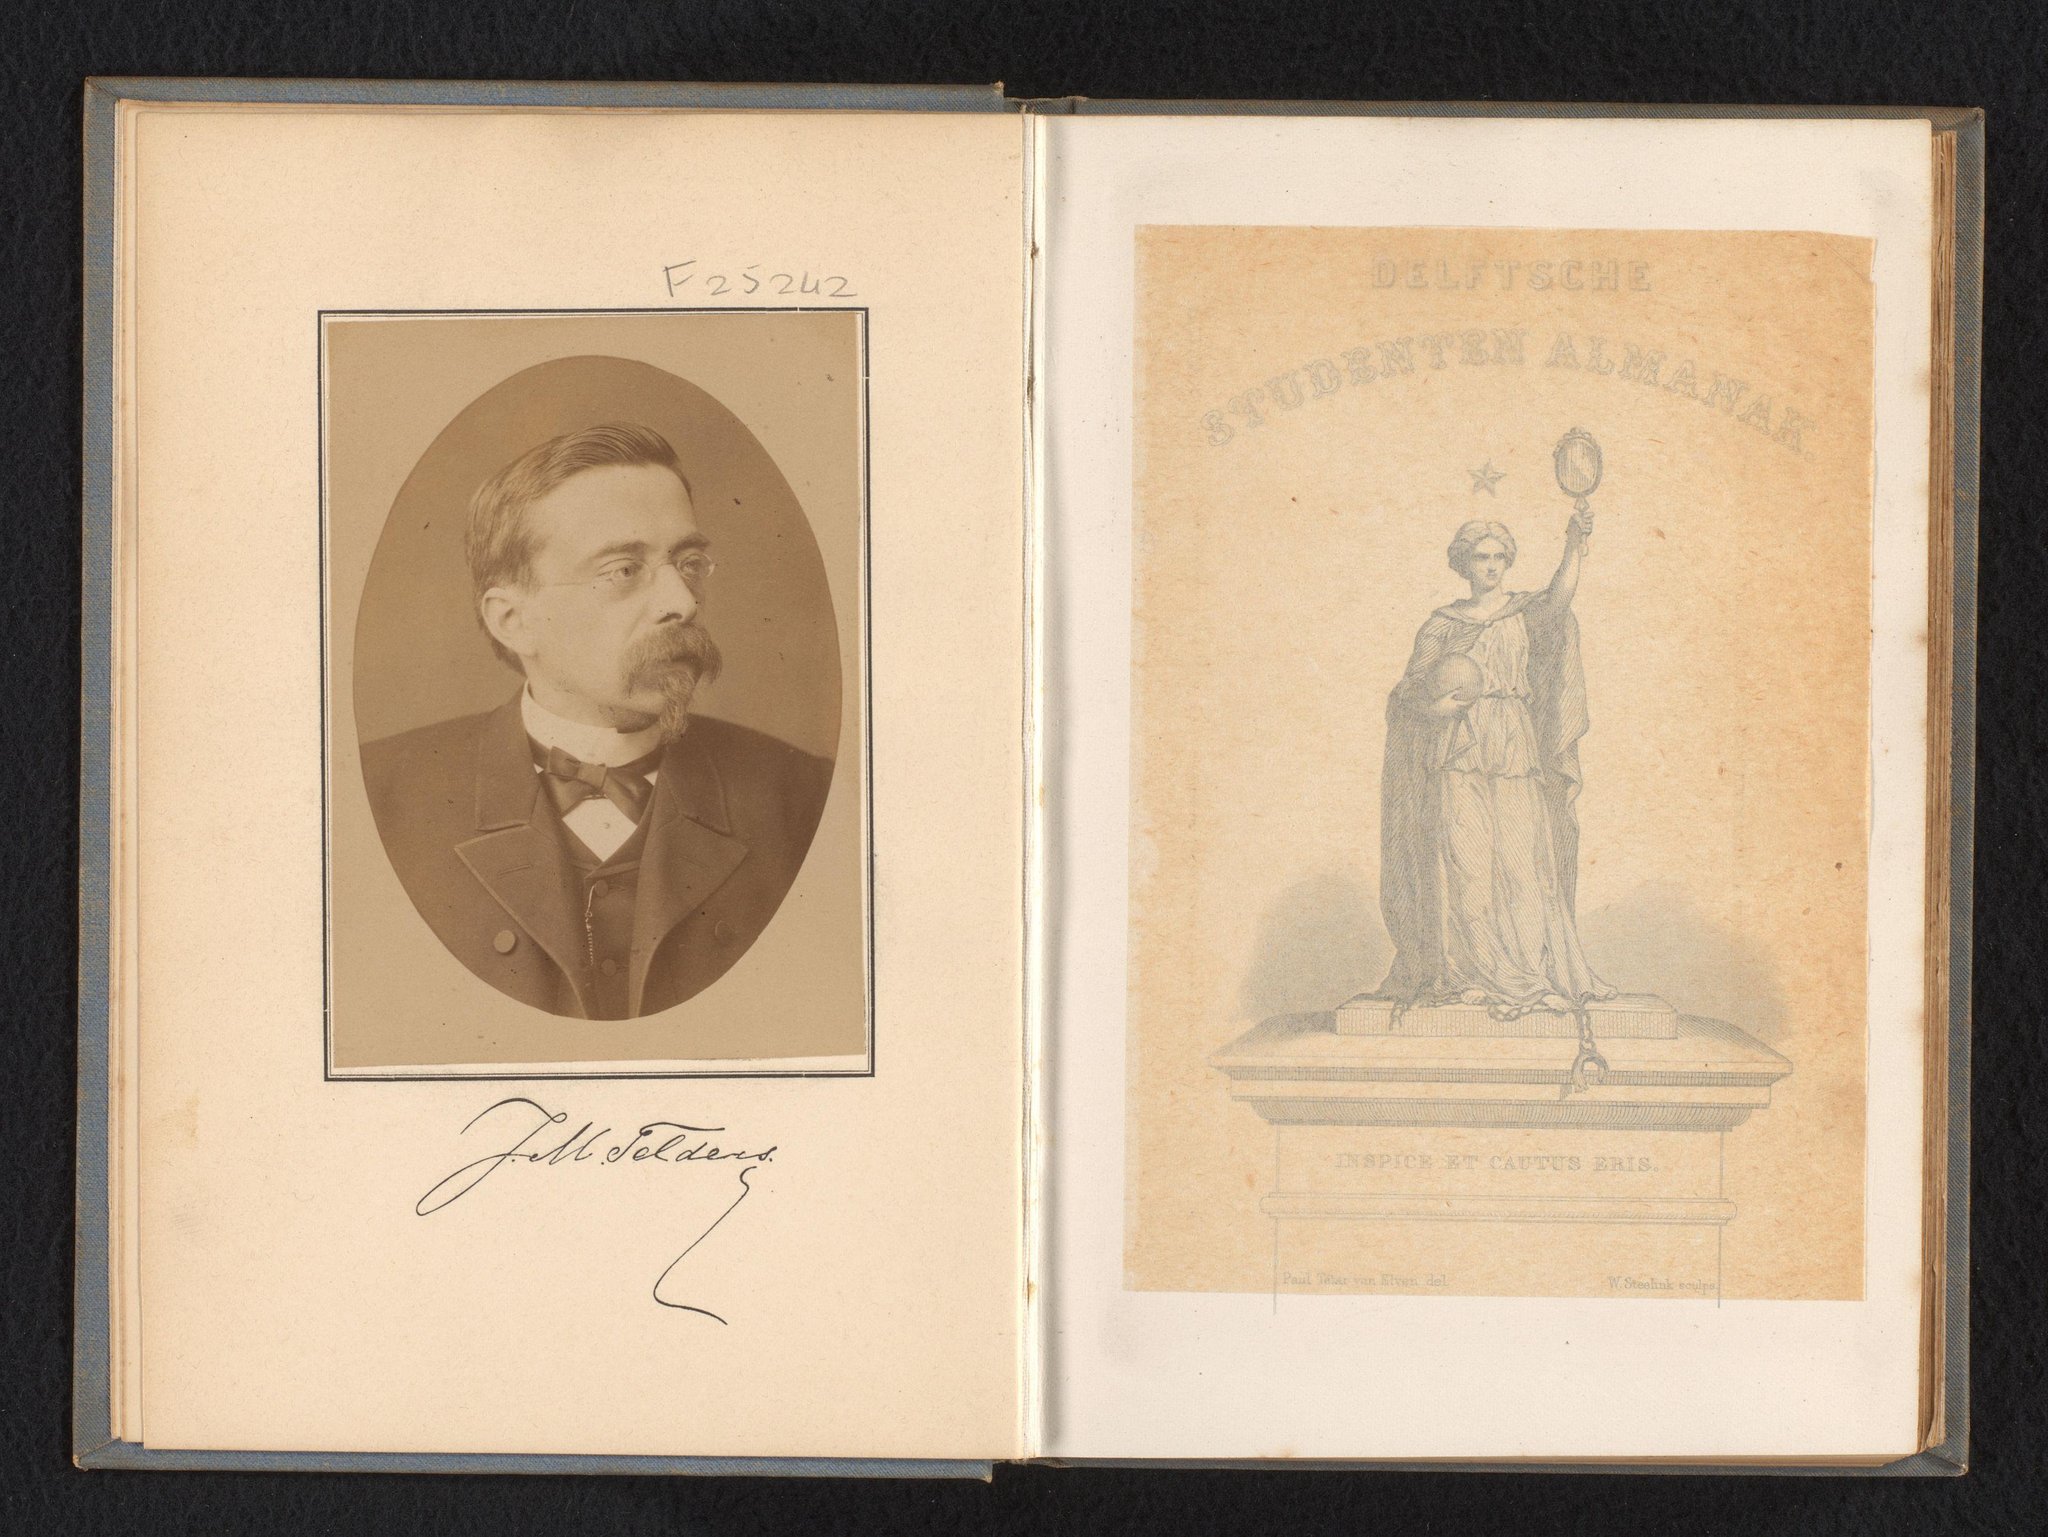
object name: photograph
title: Portret van J.M. Telders, hoogleraar waterbouwkunde aan de Polytechnische School Delft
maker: Anonymous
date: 1888-1889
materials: paper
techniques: albumen print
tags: den bosch, delft, engineer, historical persons, professor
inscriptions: signature: ‘J.M. Telders’